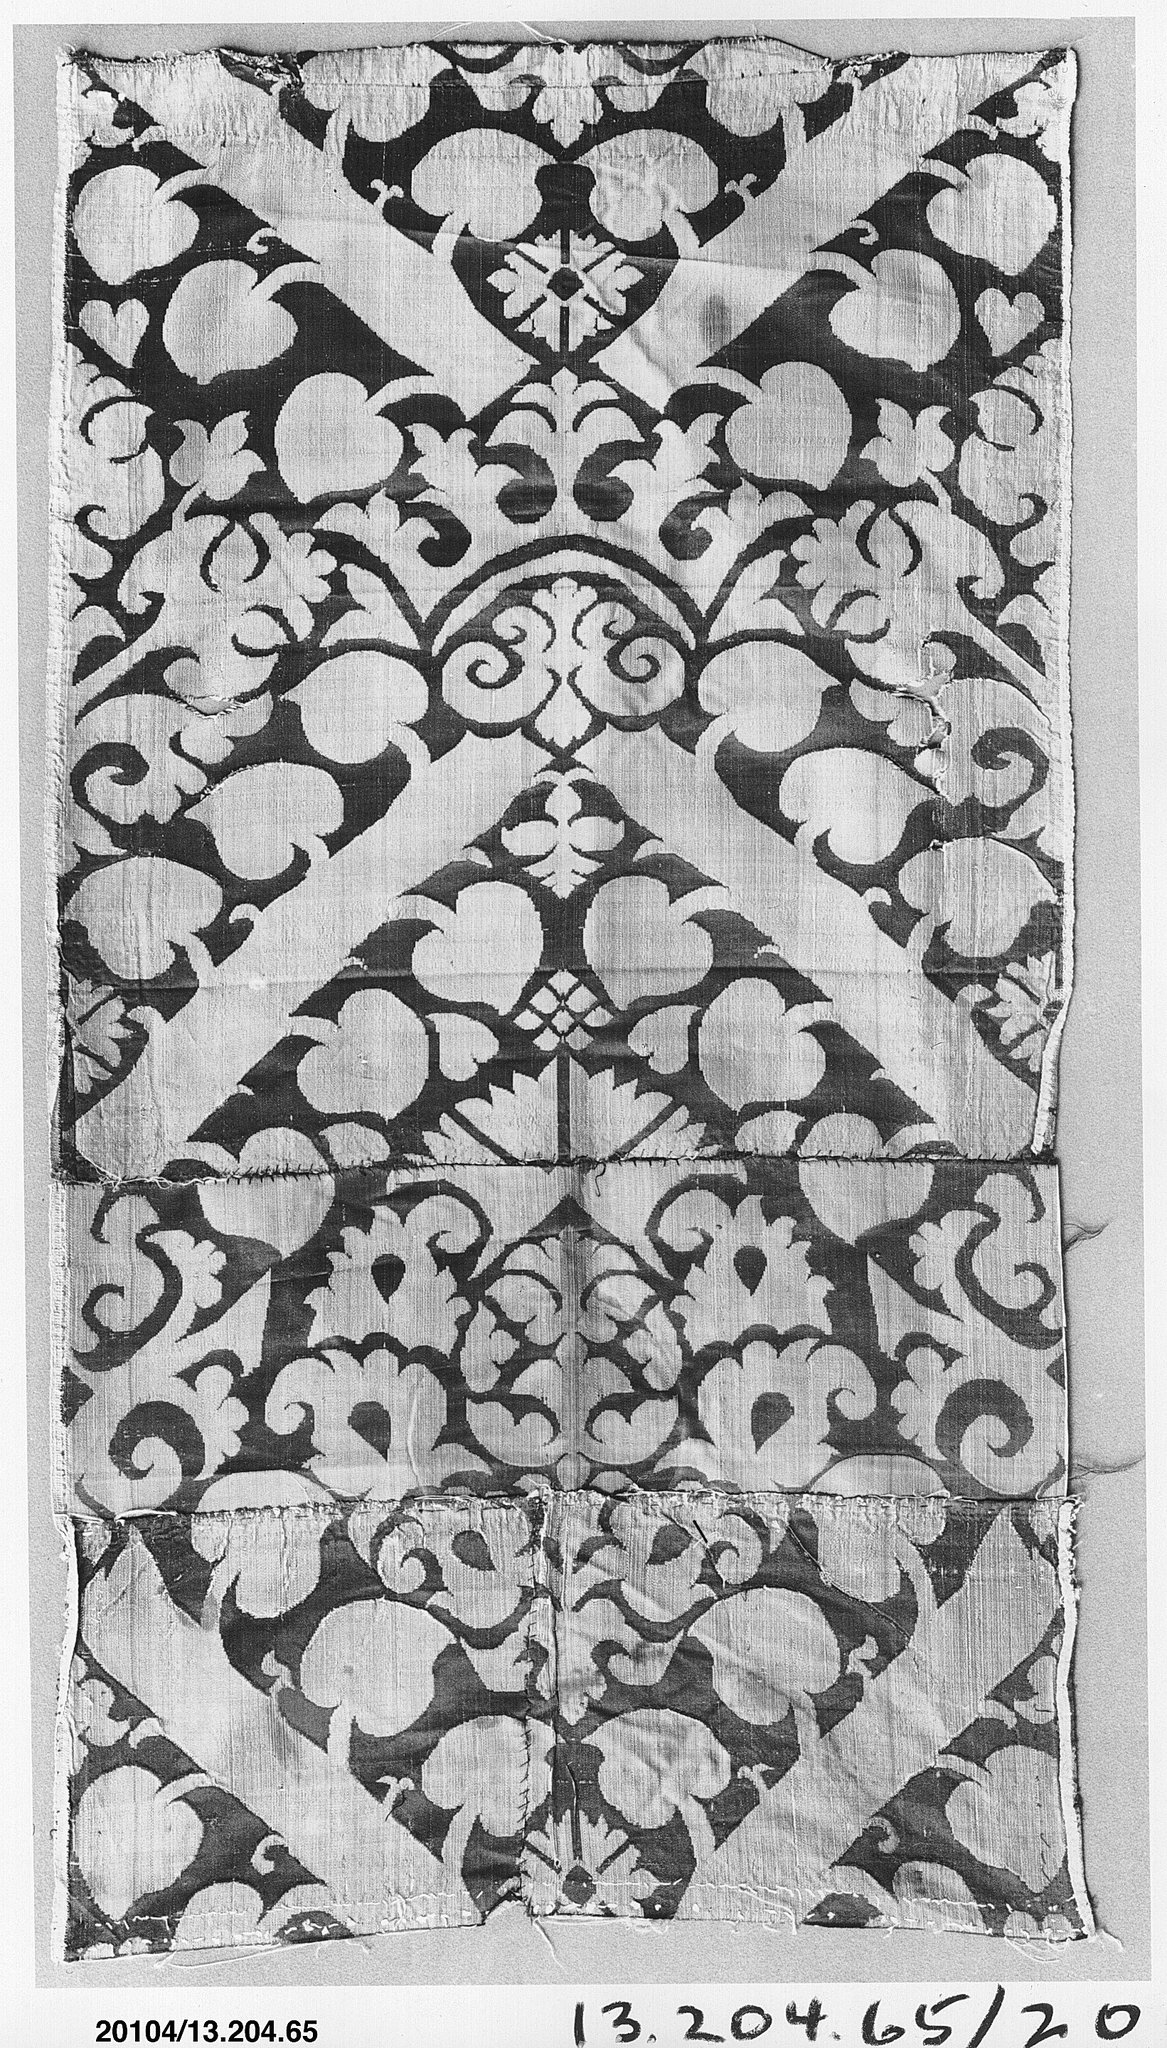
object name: piece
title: Pieces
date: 1534-1566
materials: silk